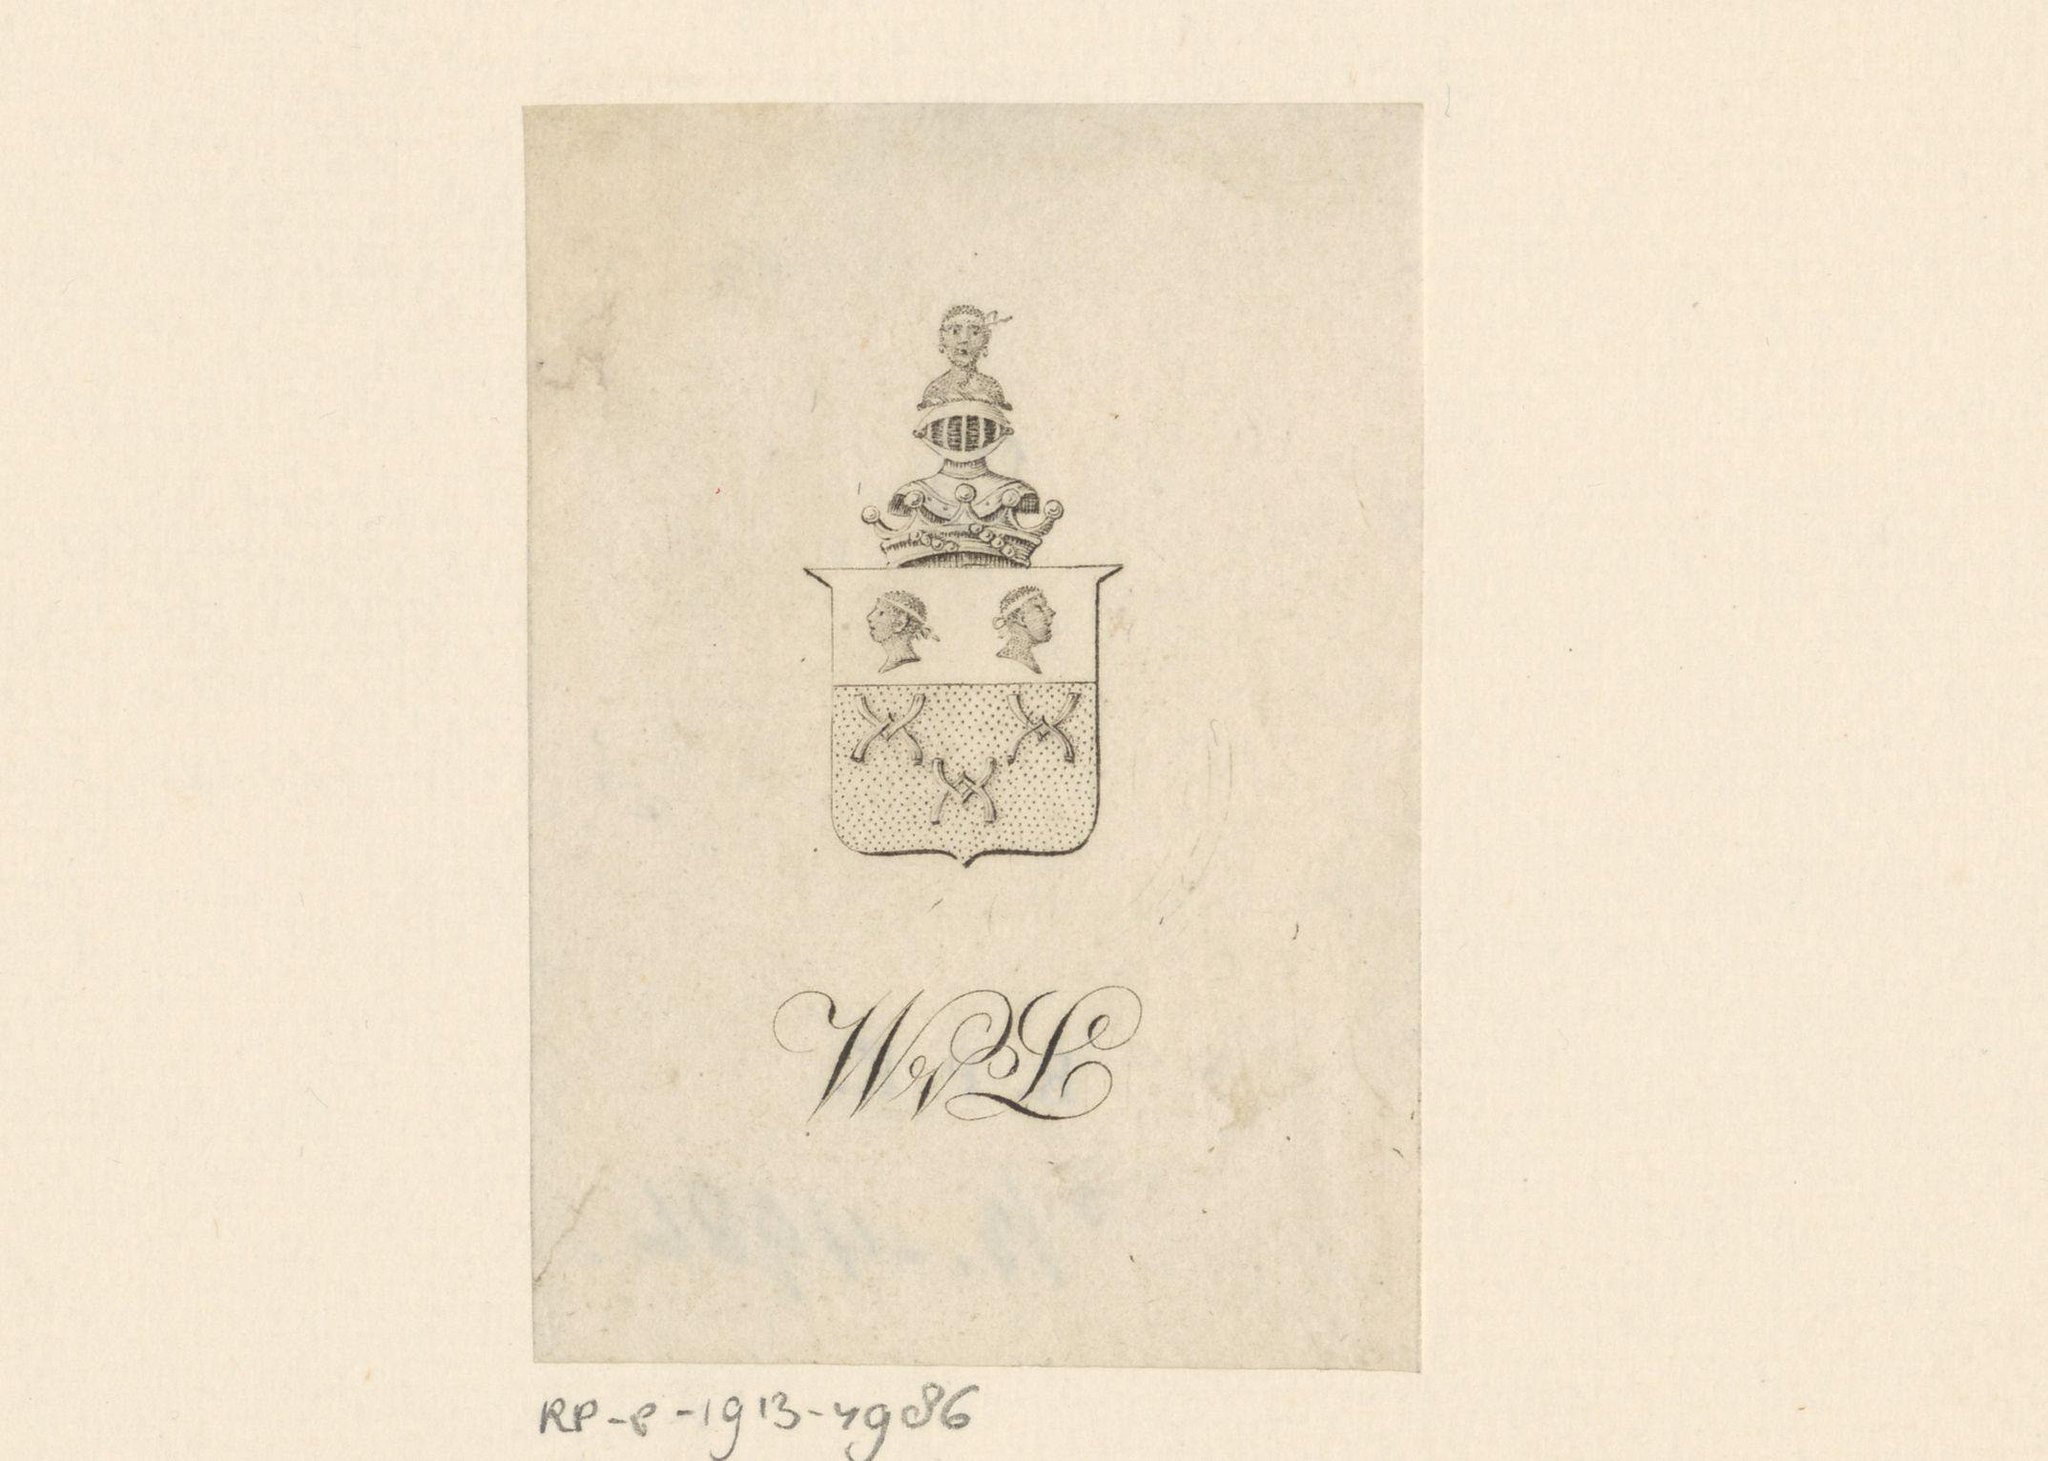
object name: bookplate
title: Ex libris van Willem van Loon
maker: Anonymous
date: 1750-1899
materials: paper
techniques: etching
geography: netherlands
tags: amsterdam, head (human), armorial bearing, heraldry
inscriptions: collector's mark: Lugt 2233, collector's mark: Lugt 2760